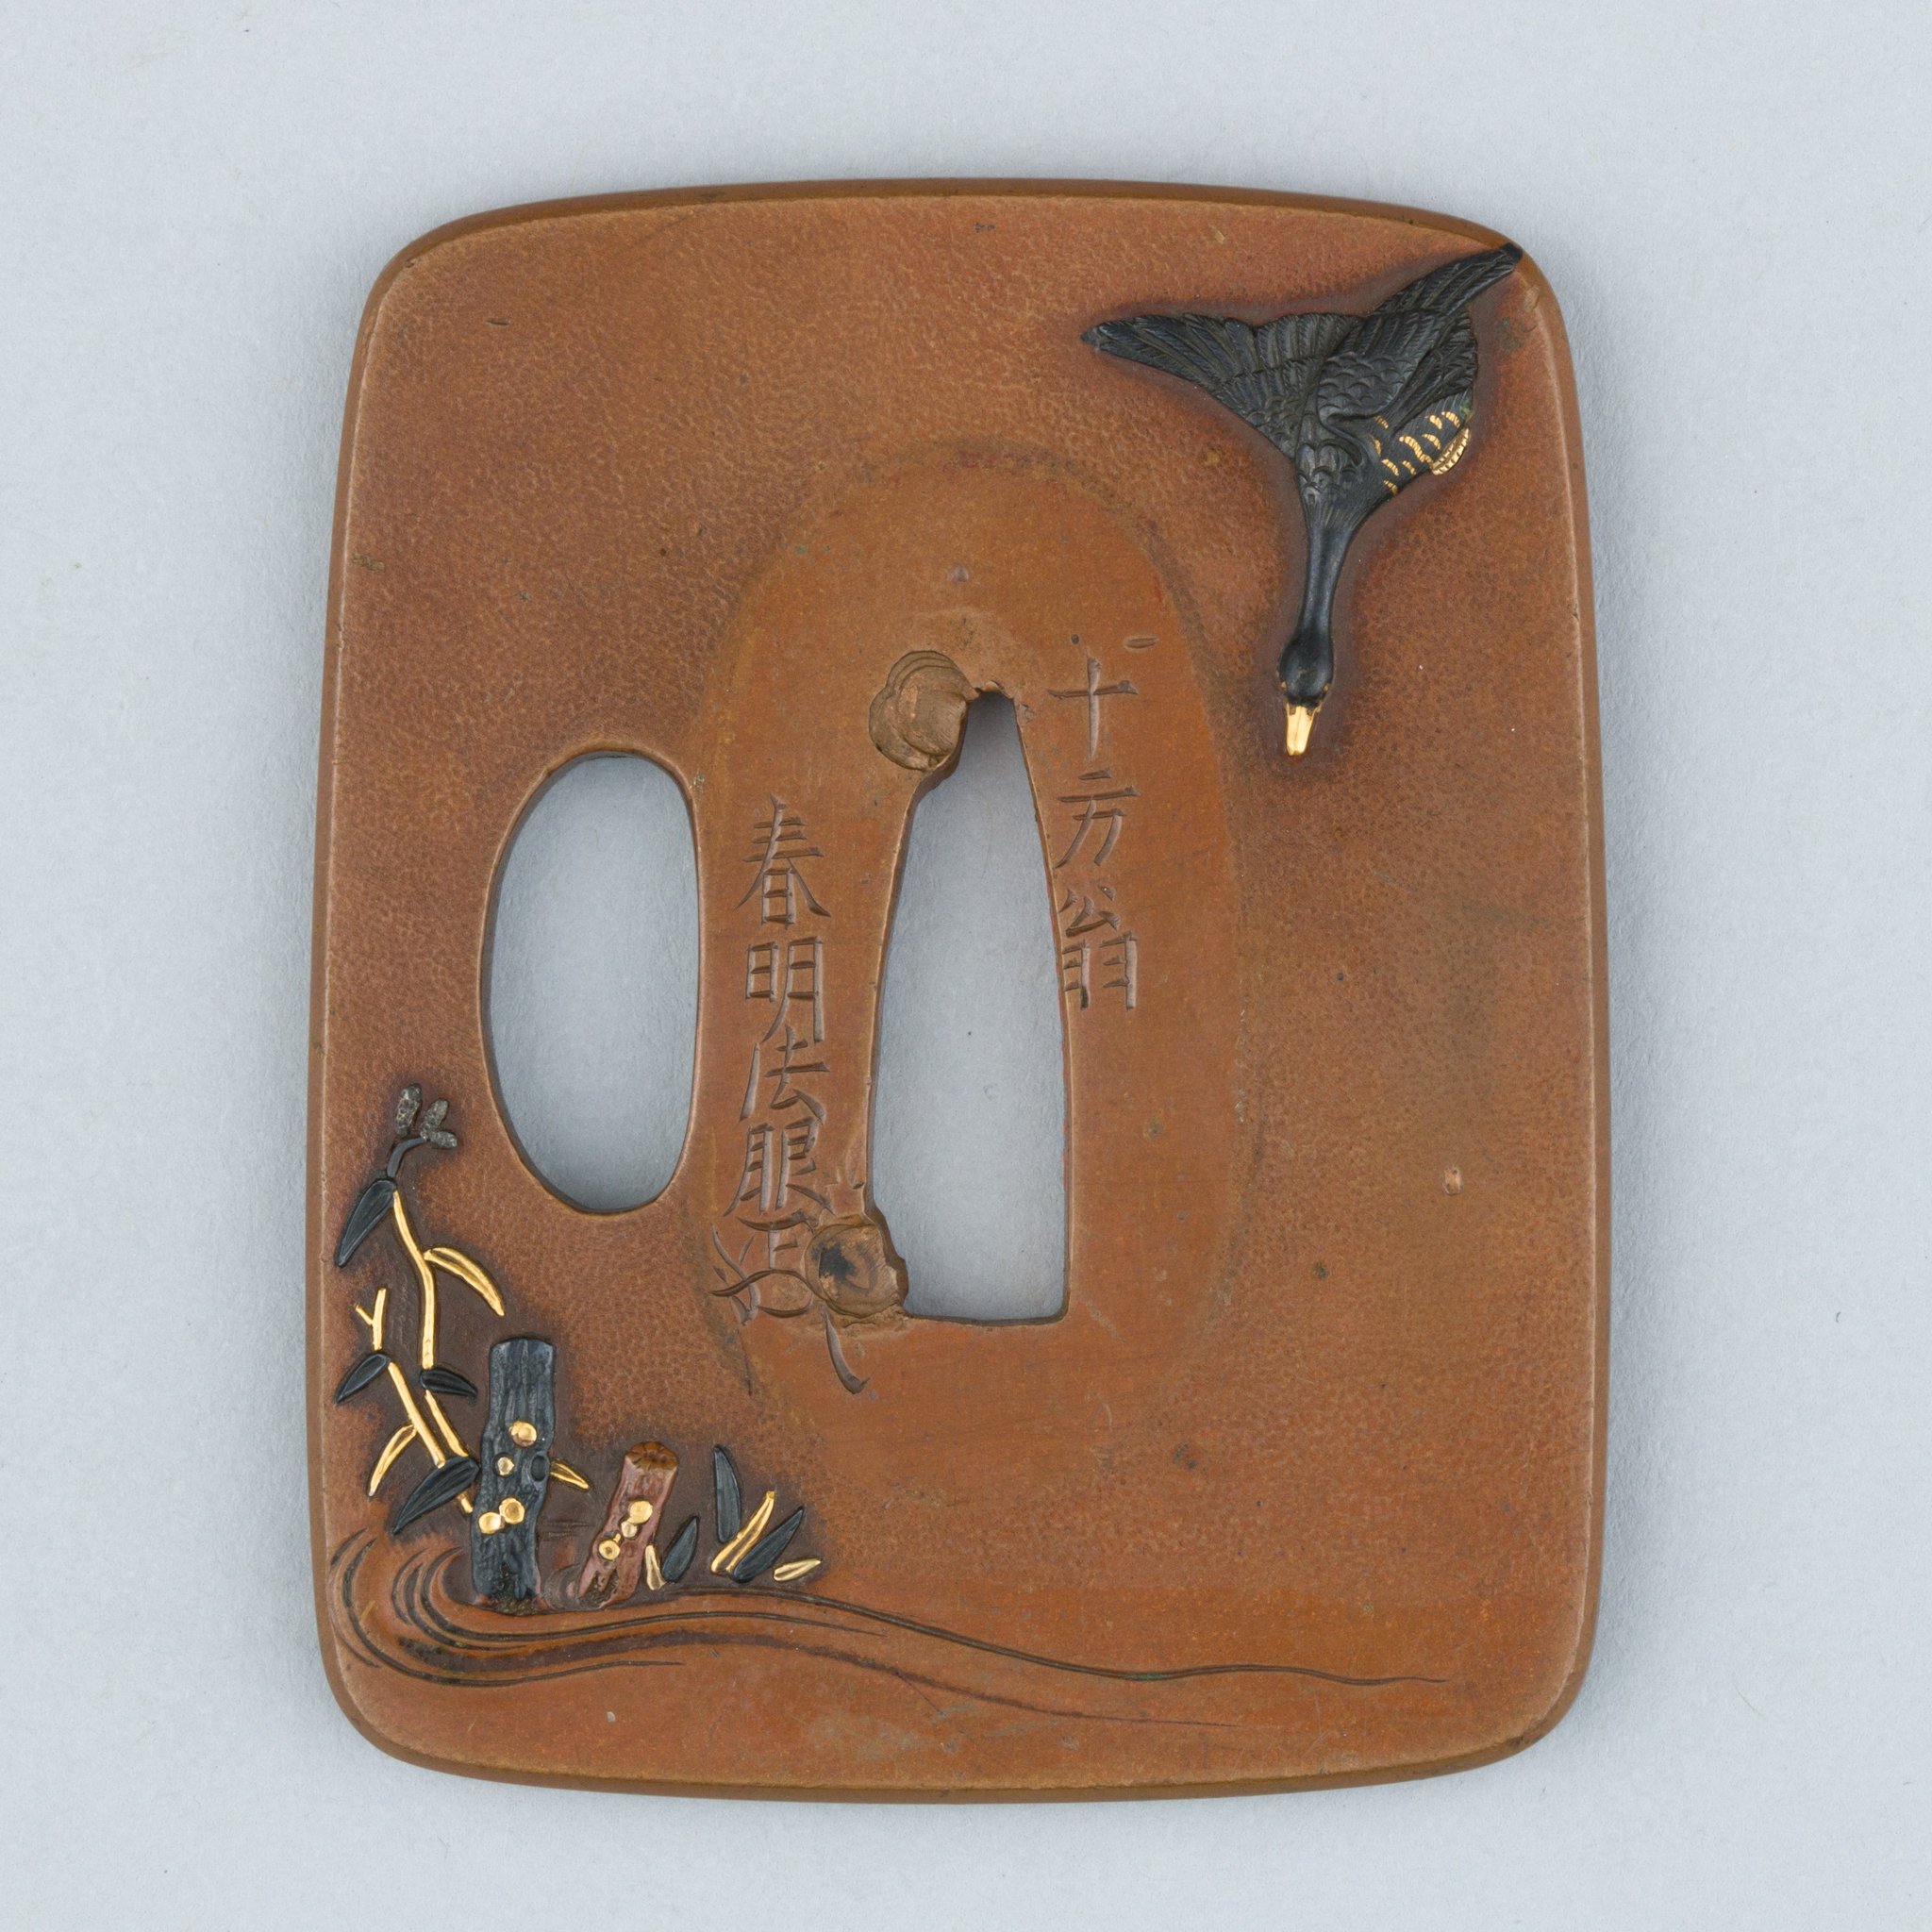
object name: sword guard tsuba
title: Sword Guard (Tsuba)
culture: japanese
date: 1786-1859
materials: copper, copper alloy, gold alloy, gold, silver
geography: japan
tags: birds